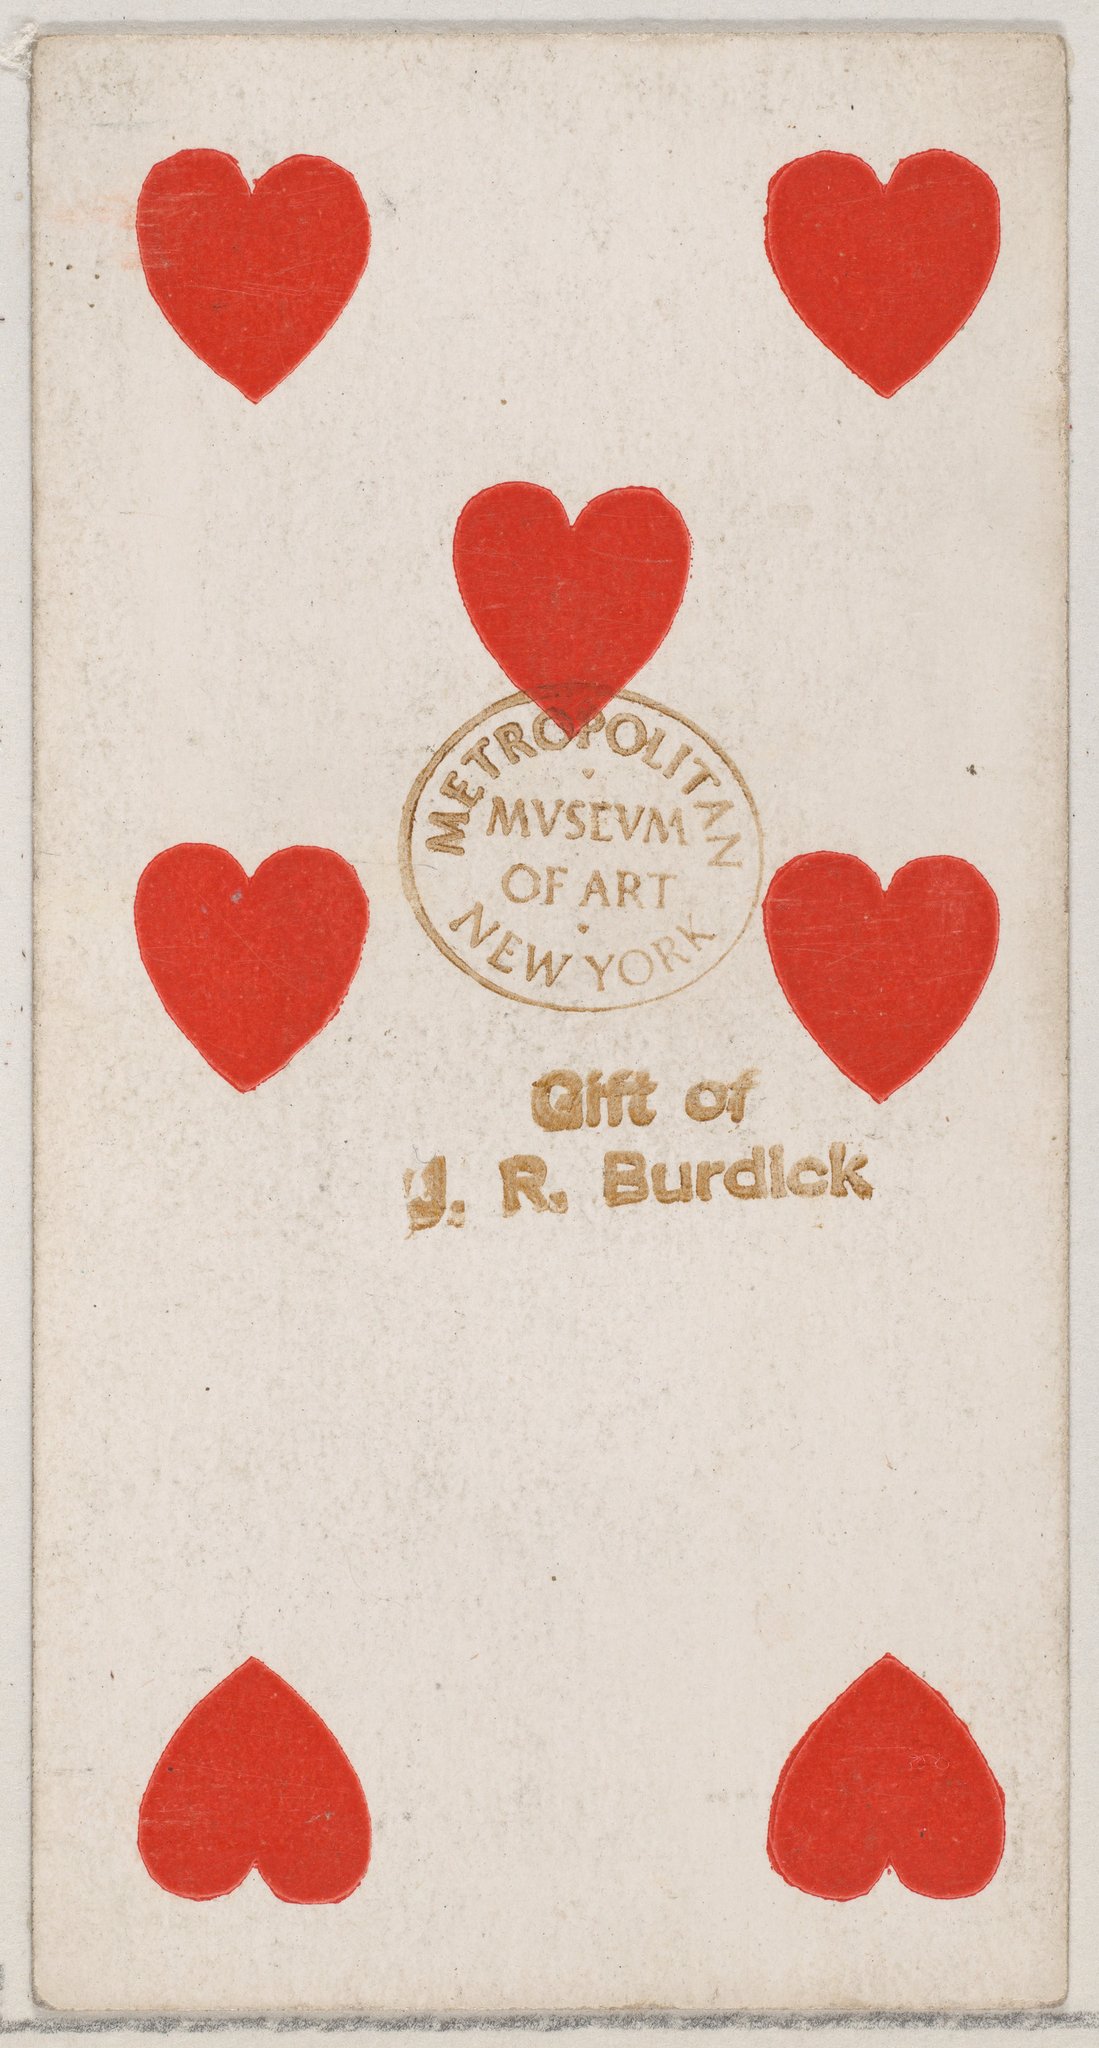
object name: print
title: Seven Hearts, from the Playing Cards series (N84) to promote Turkish Cross-Cut Cigarettes for W. Duke, Sons and Co.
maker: w. duke, sons & co.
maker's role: publisher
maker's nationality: american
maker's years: 1870-1920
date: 1888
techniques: color lithograph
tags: playing cards